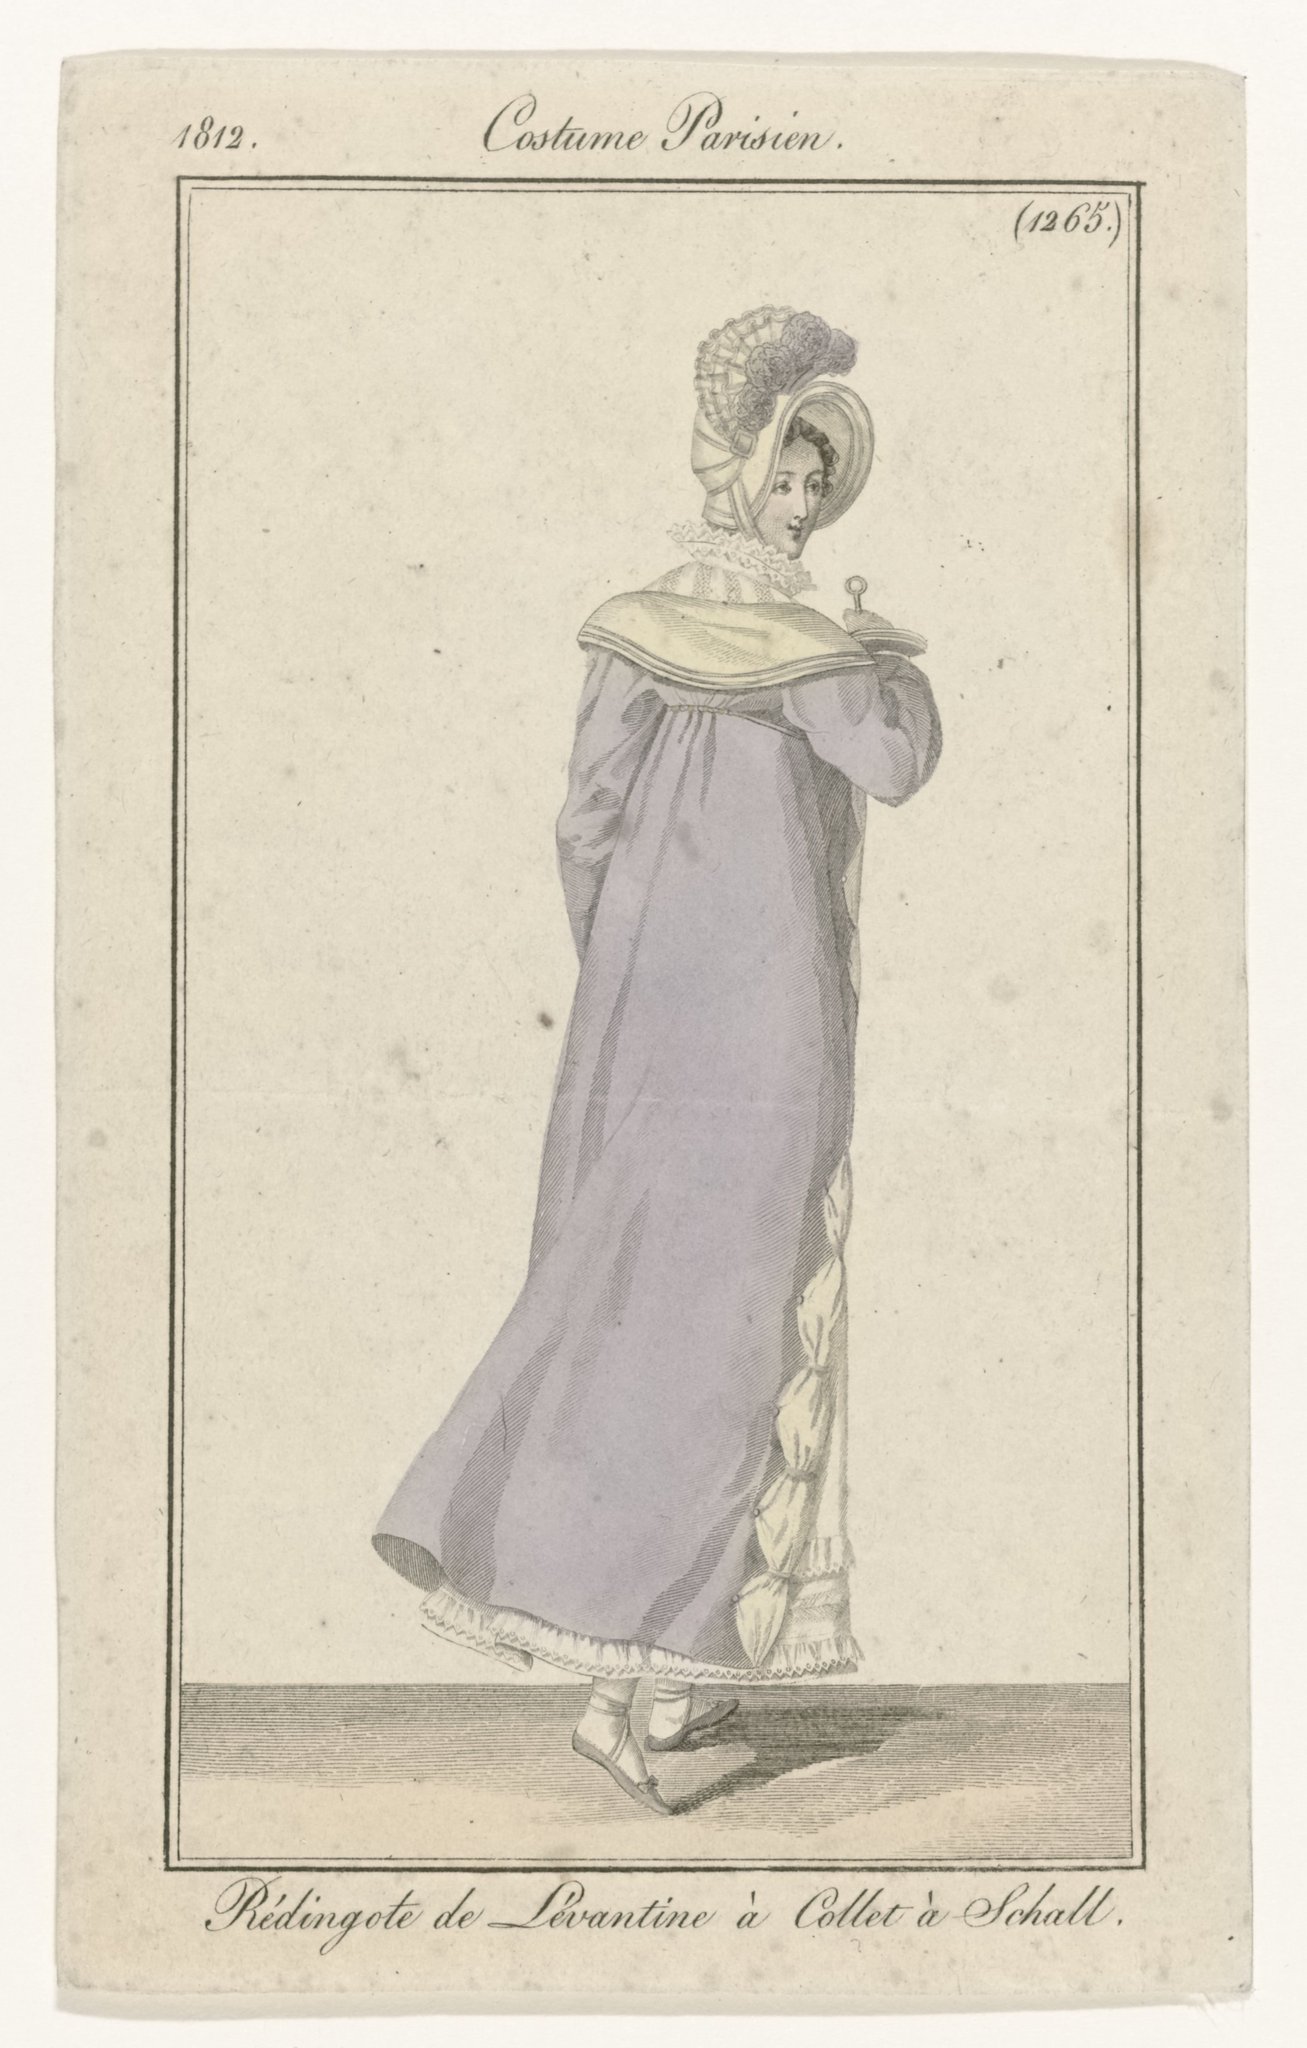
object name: fashion print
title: Journal des Dames et des Modes, Costume Parisien, 1812, (1265): Rédingote de Lévantin (...)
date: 1812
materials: paper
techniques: engraving, hand coloring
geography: paris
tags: dress, gown: redingote (+ women's clothes), monocle, single lorgnette - aa - female human figure, neck-gear: collar (+ women's clothes), fashion plates, head-gear: hat (+ women's clothes), shoes, sandals (+ women's clothes), dress, gown (+ women's clothes)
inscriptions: title: ‘Costume Parisien.’, caption: ‘Rédingote de Lévantine à Collet à Shall.’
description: Vrouw, op de rug gezien, gekleed in een 'redingote de Lévantine' met 'Collet à Schall' (sjaalkraag?). Accessoires: luifelhoed, lorgnet, platte schoenen met puntige neuzen. De prent maakt deel uit van het modetijdschrift Journal des Dames et des Modes, uitgegeven door Pierre de la Mésangère, Parijs, 1797-1839.